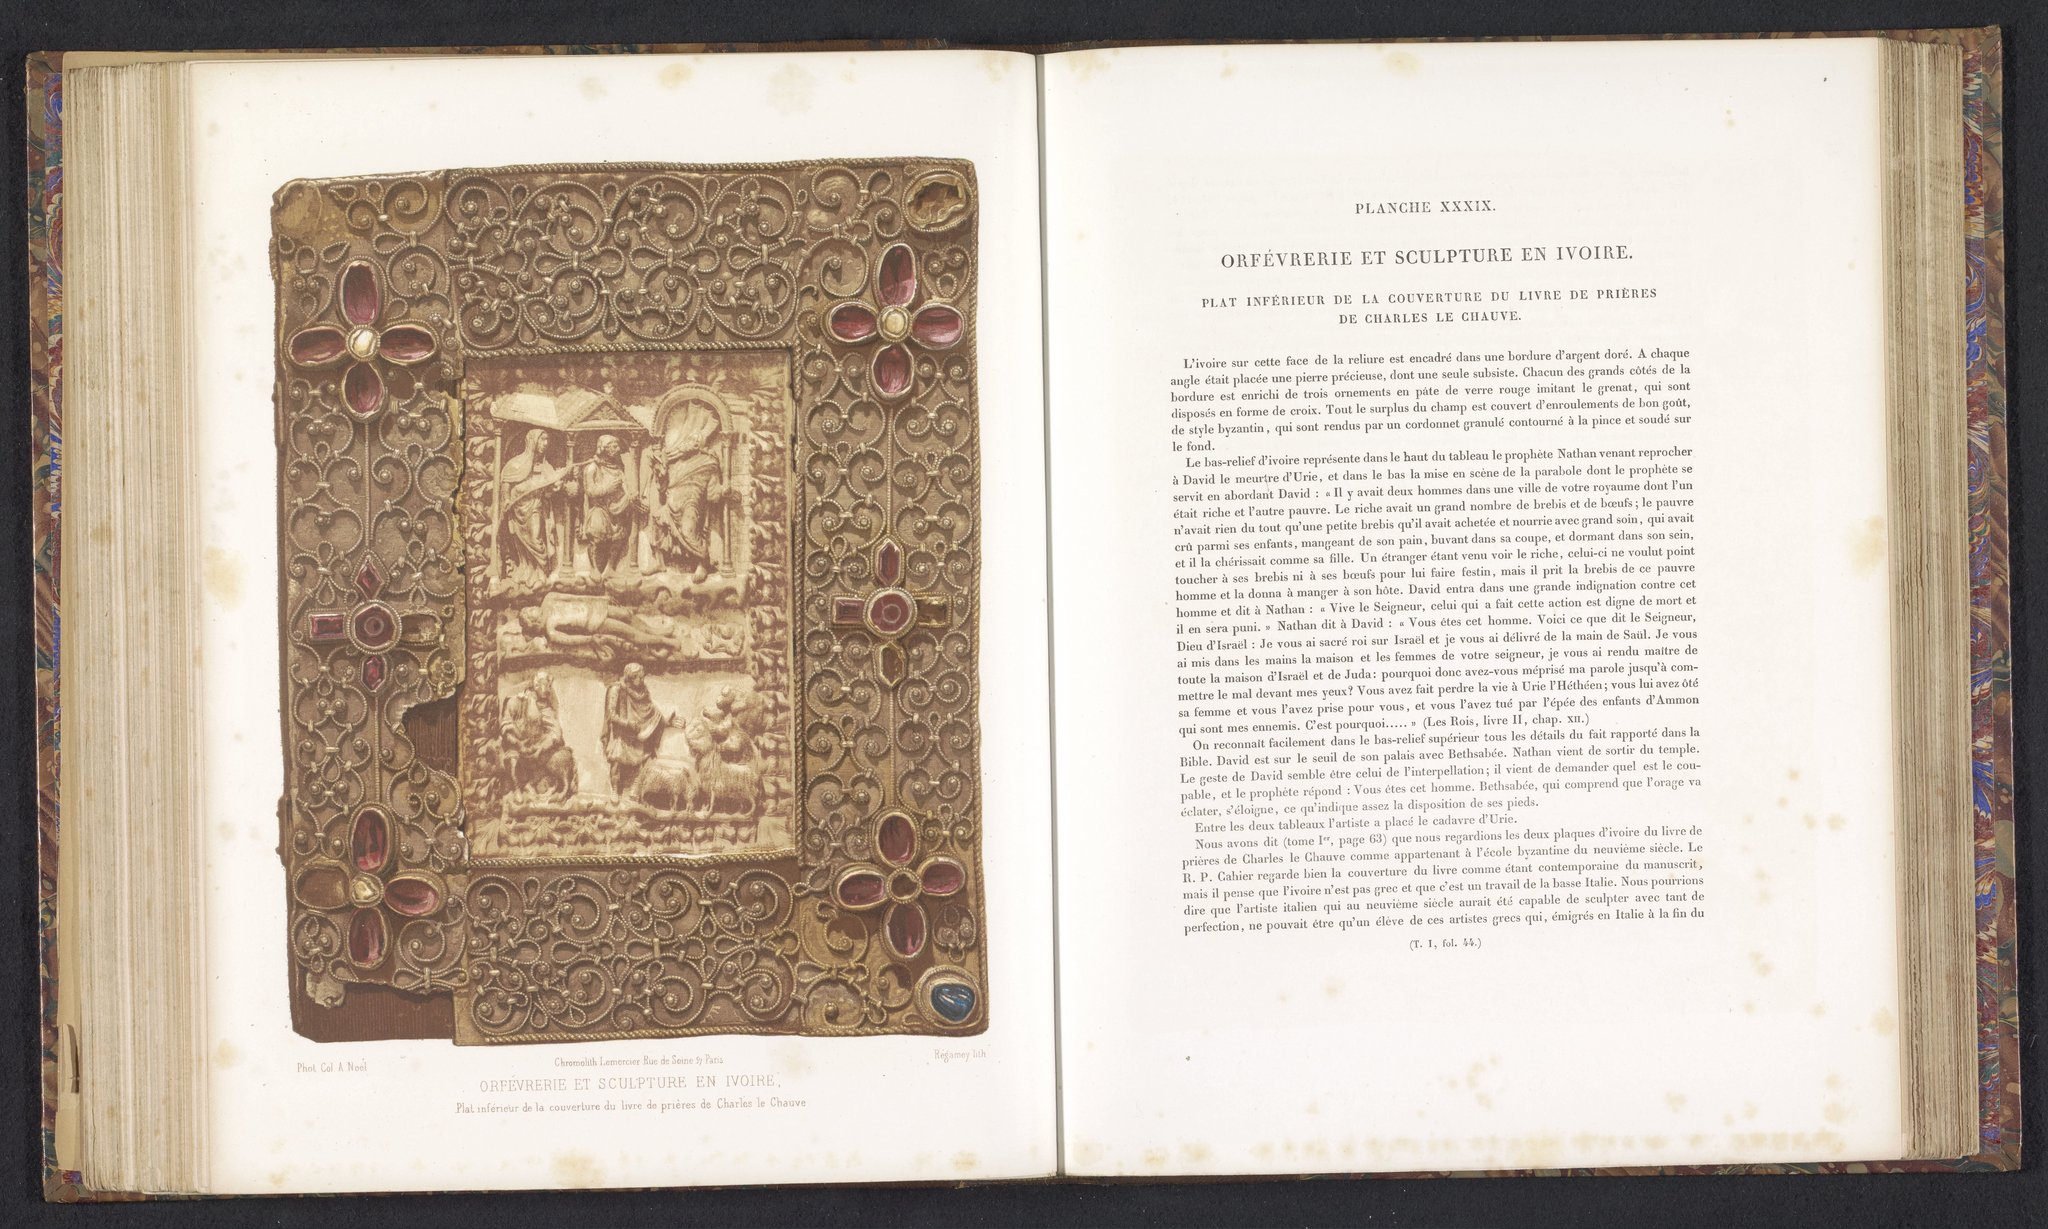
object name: page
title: Achterplat van het gebedenboek van koning Karel de Kale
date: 1859-1864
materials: paper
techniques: chromolithography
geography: paris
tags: book-cover, binding, gem, gemstone